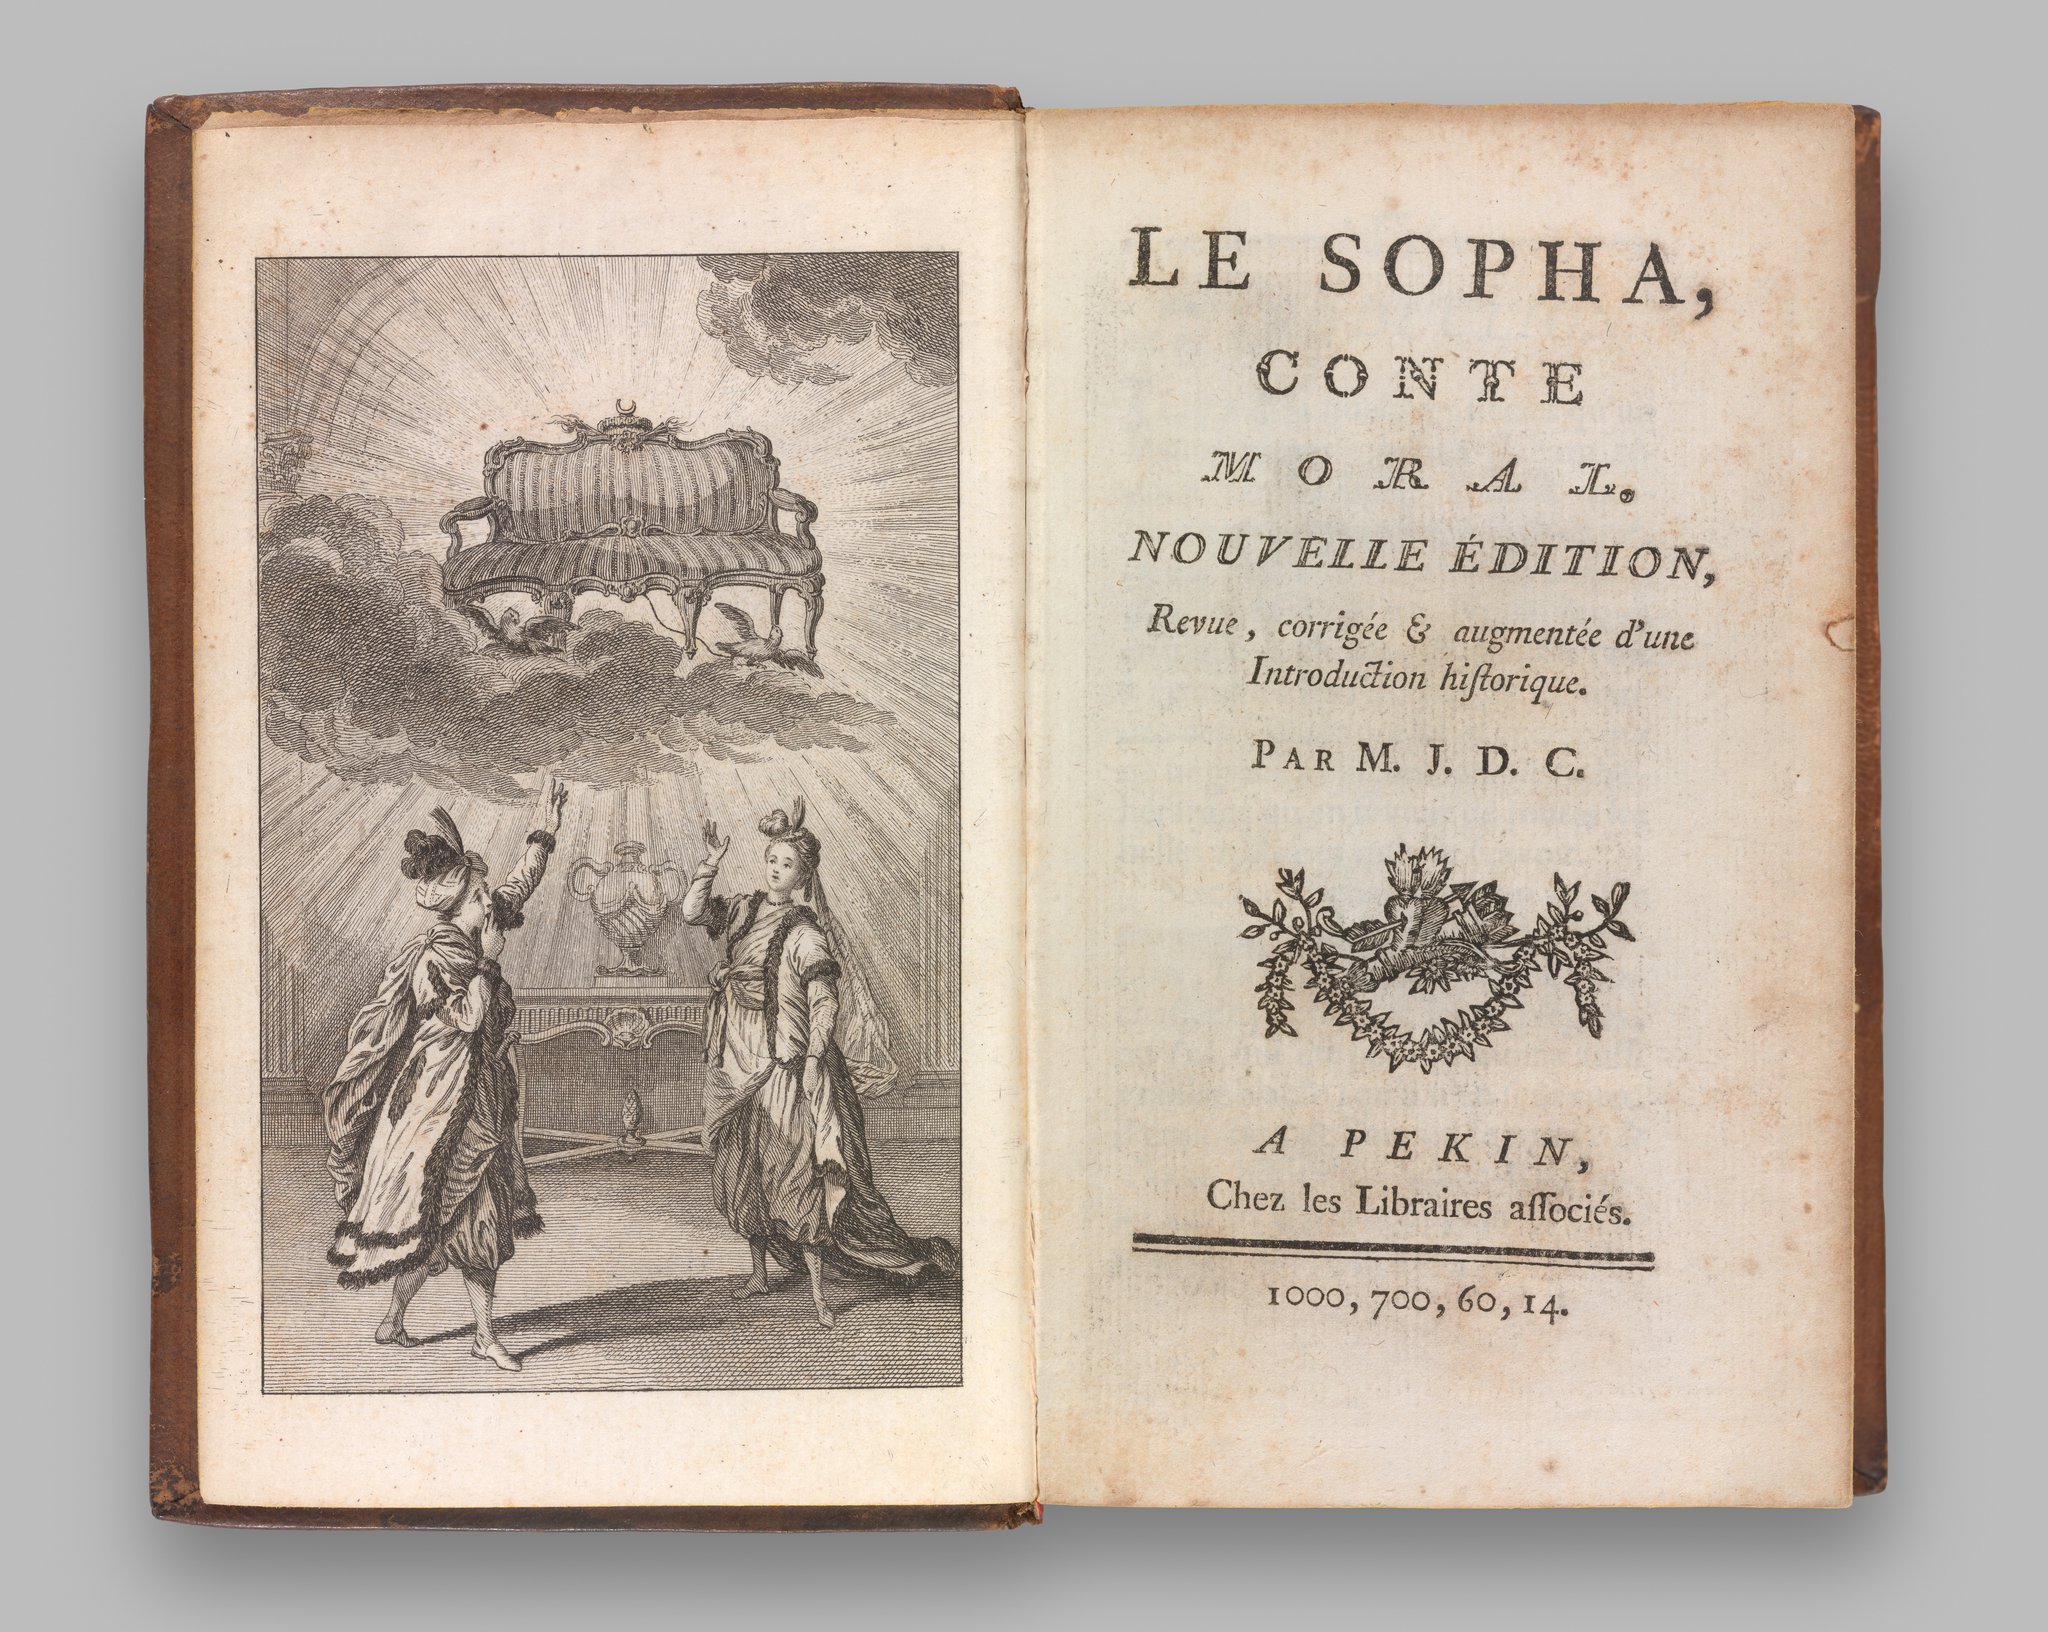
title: Le sopha : conte moral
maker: claude-prosper jolyot de crébillon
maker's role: author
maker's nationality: french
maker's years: 1707-1777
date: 1774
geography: france